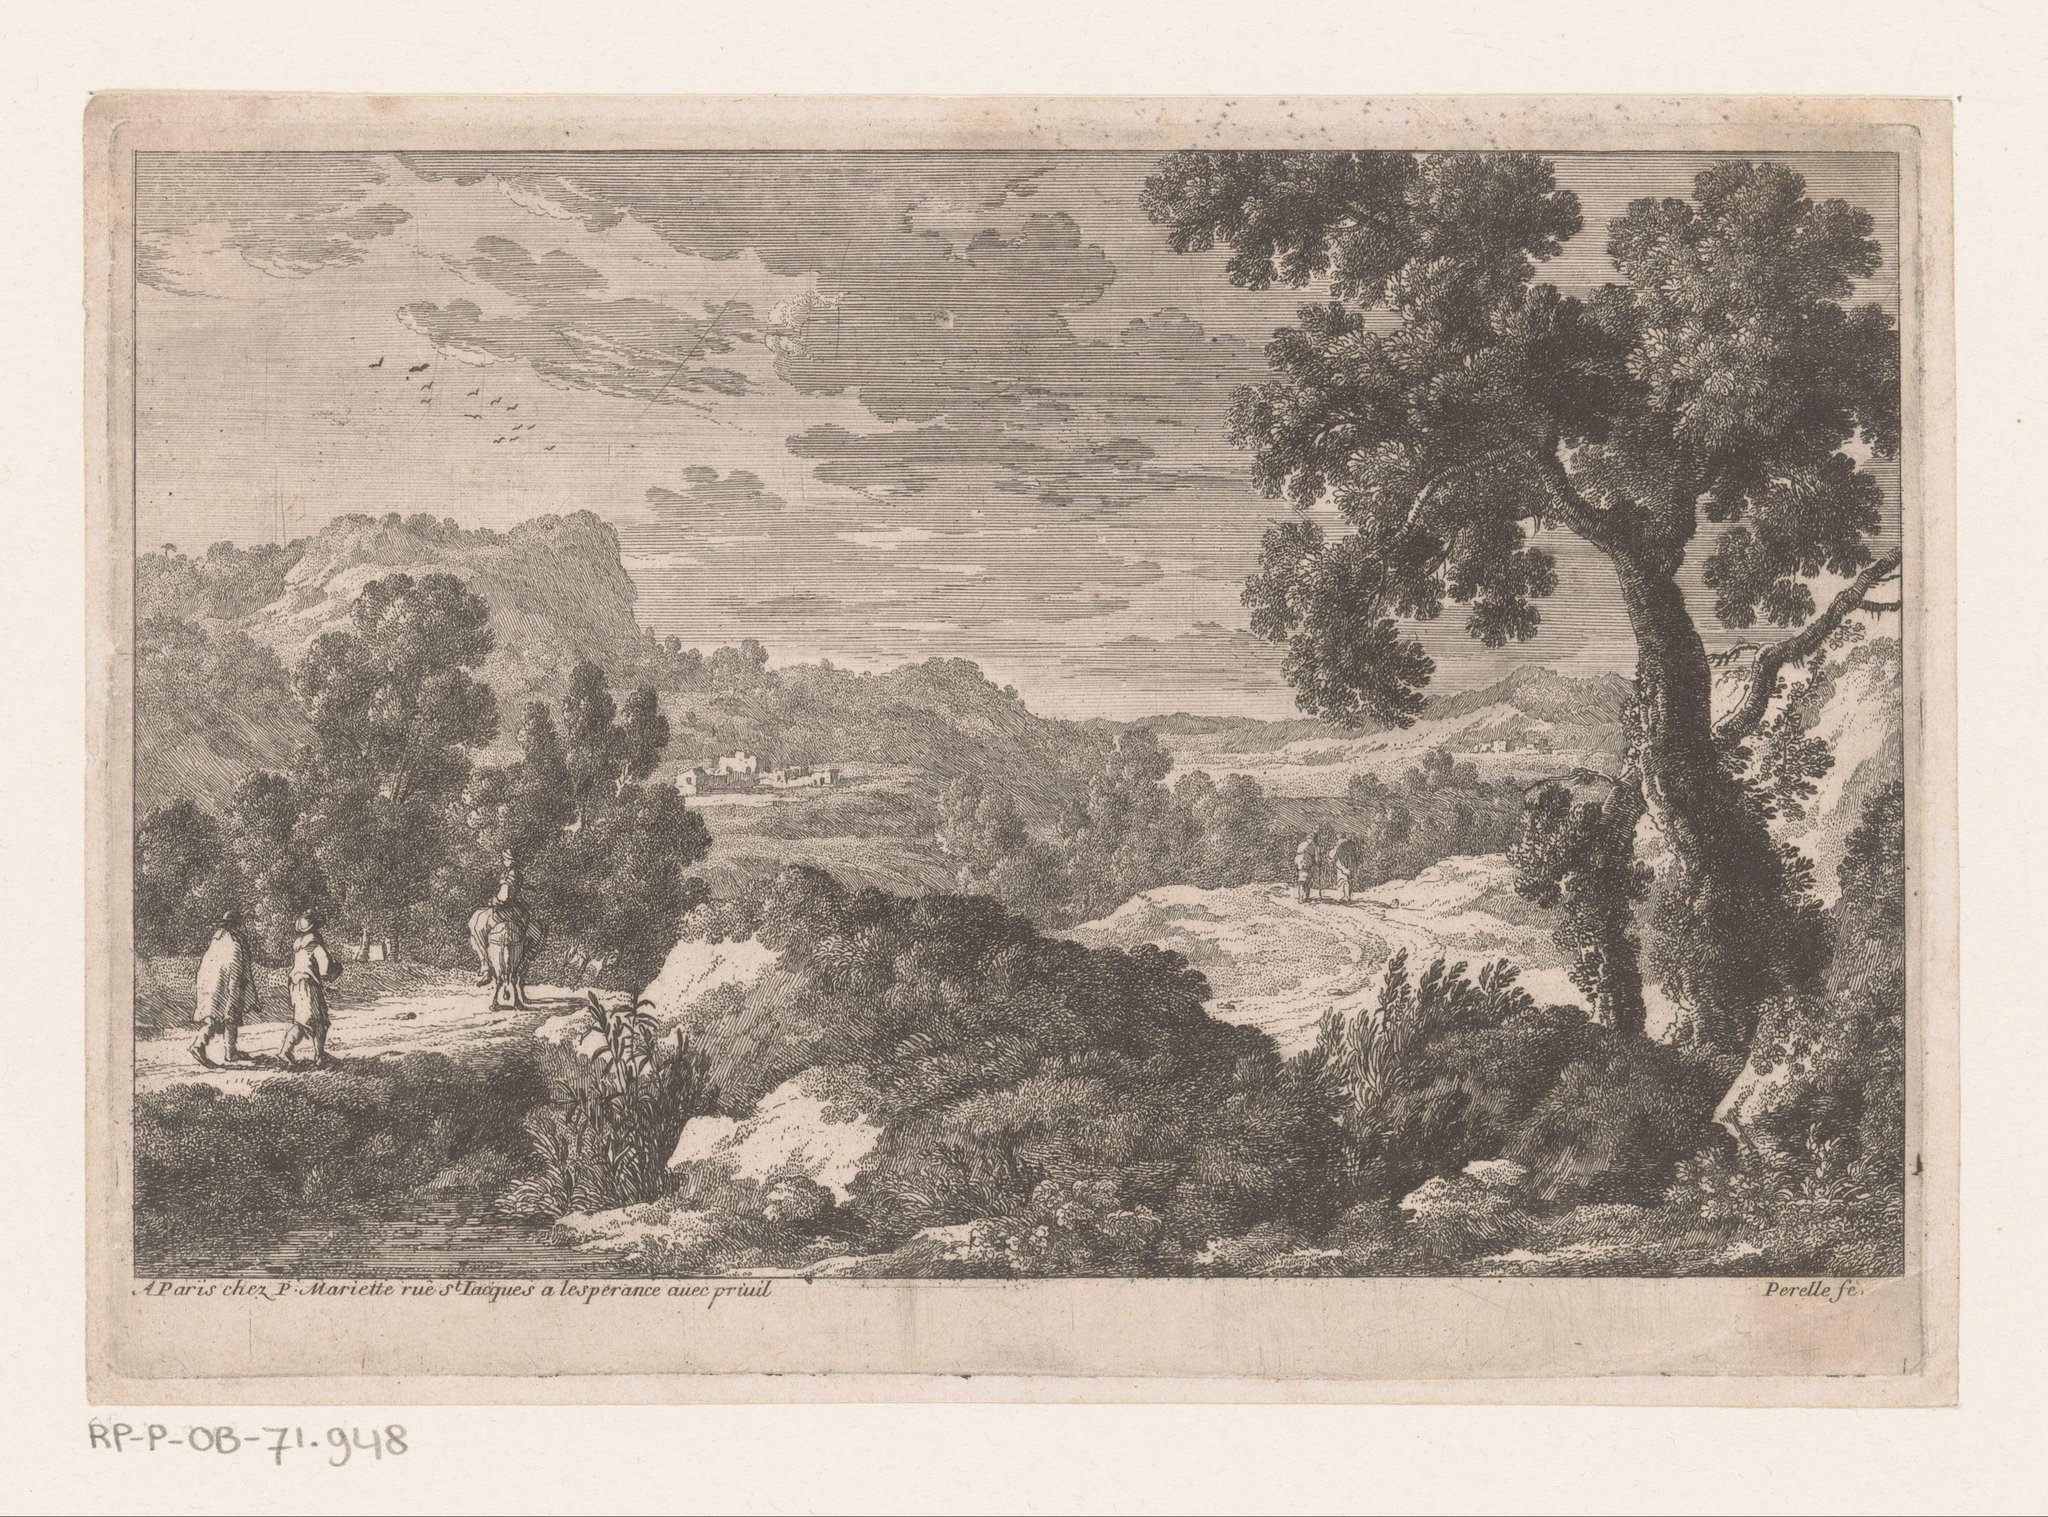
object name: print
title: Landschap met reizigers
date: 1613-1695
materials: paper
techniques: etching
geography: france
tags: landscapes, 'en route', traveller under way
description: Prenten met het signatuur 'Perelle' kunnen zowel door vader Gabriel als door zonen Nicolas en Adam gemaakt zijn.